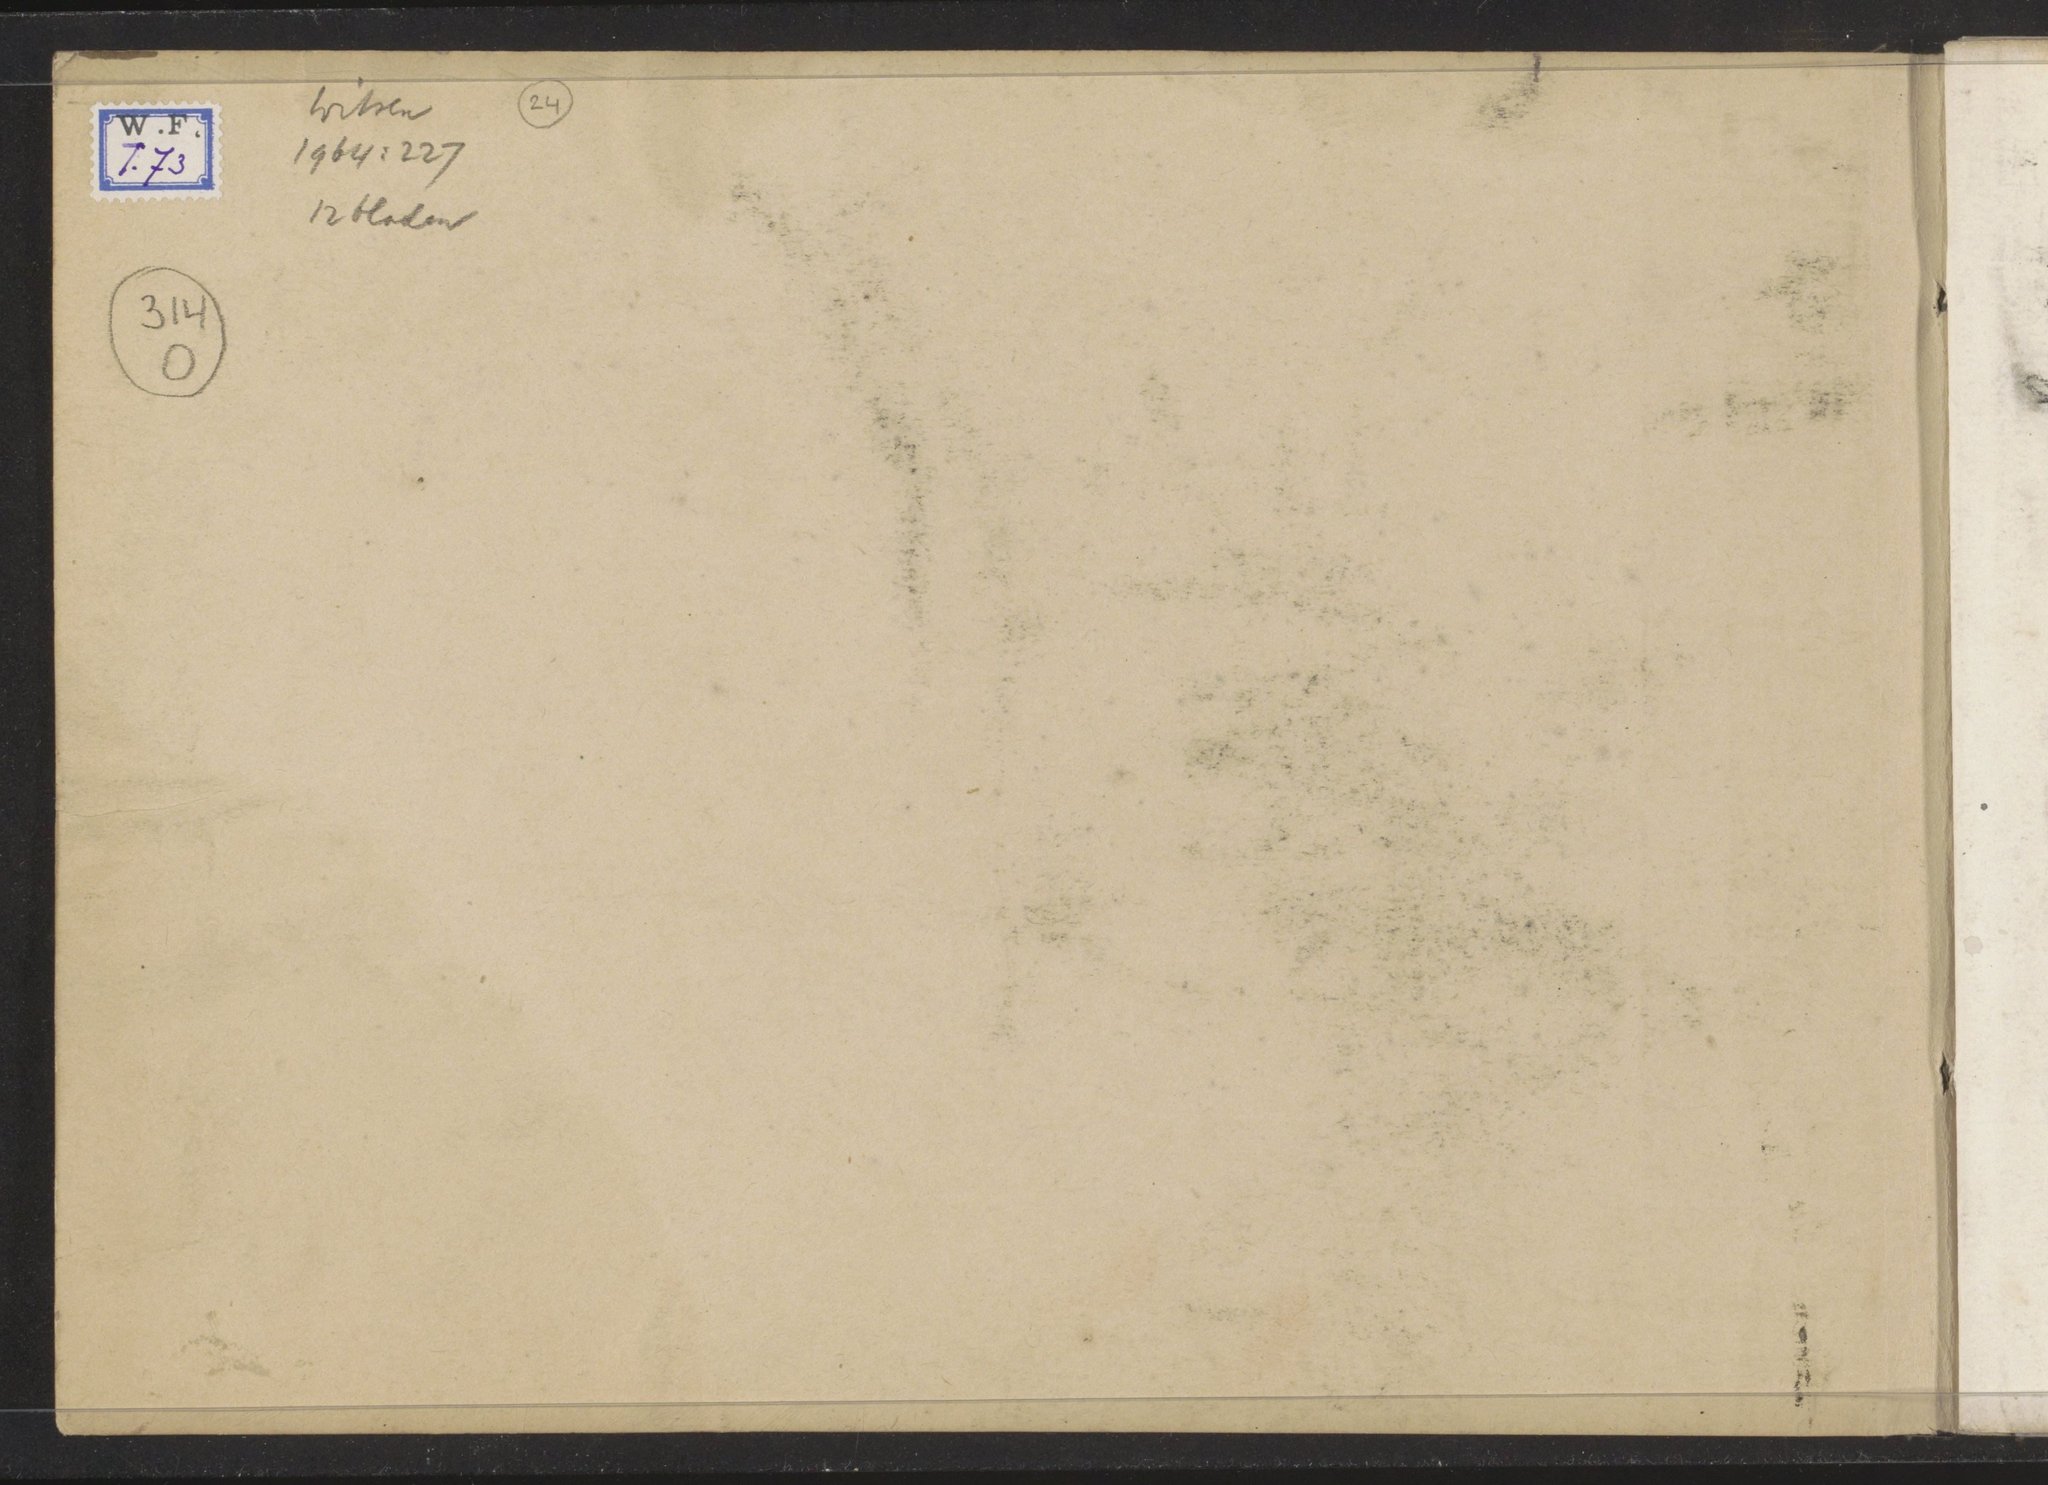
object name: sketchbook leaf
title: Abklatsch van de krijttekening op pagina 1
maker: willem witsen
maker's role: draughtsman, painter, print maker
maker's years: 1860-1923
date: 1897-1898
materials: paper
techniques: printmaking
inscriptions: annotation: ‘W.F./ T.73’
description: Schutblad A, voorste schutblad, uit een schetsboek met 12 bladen.